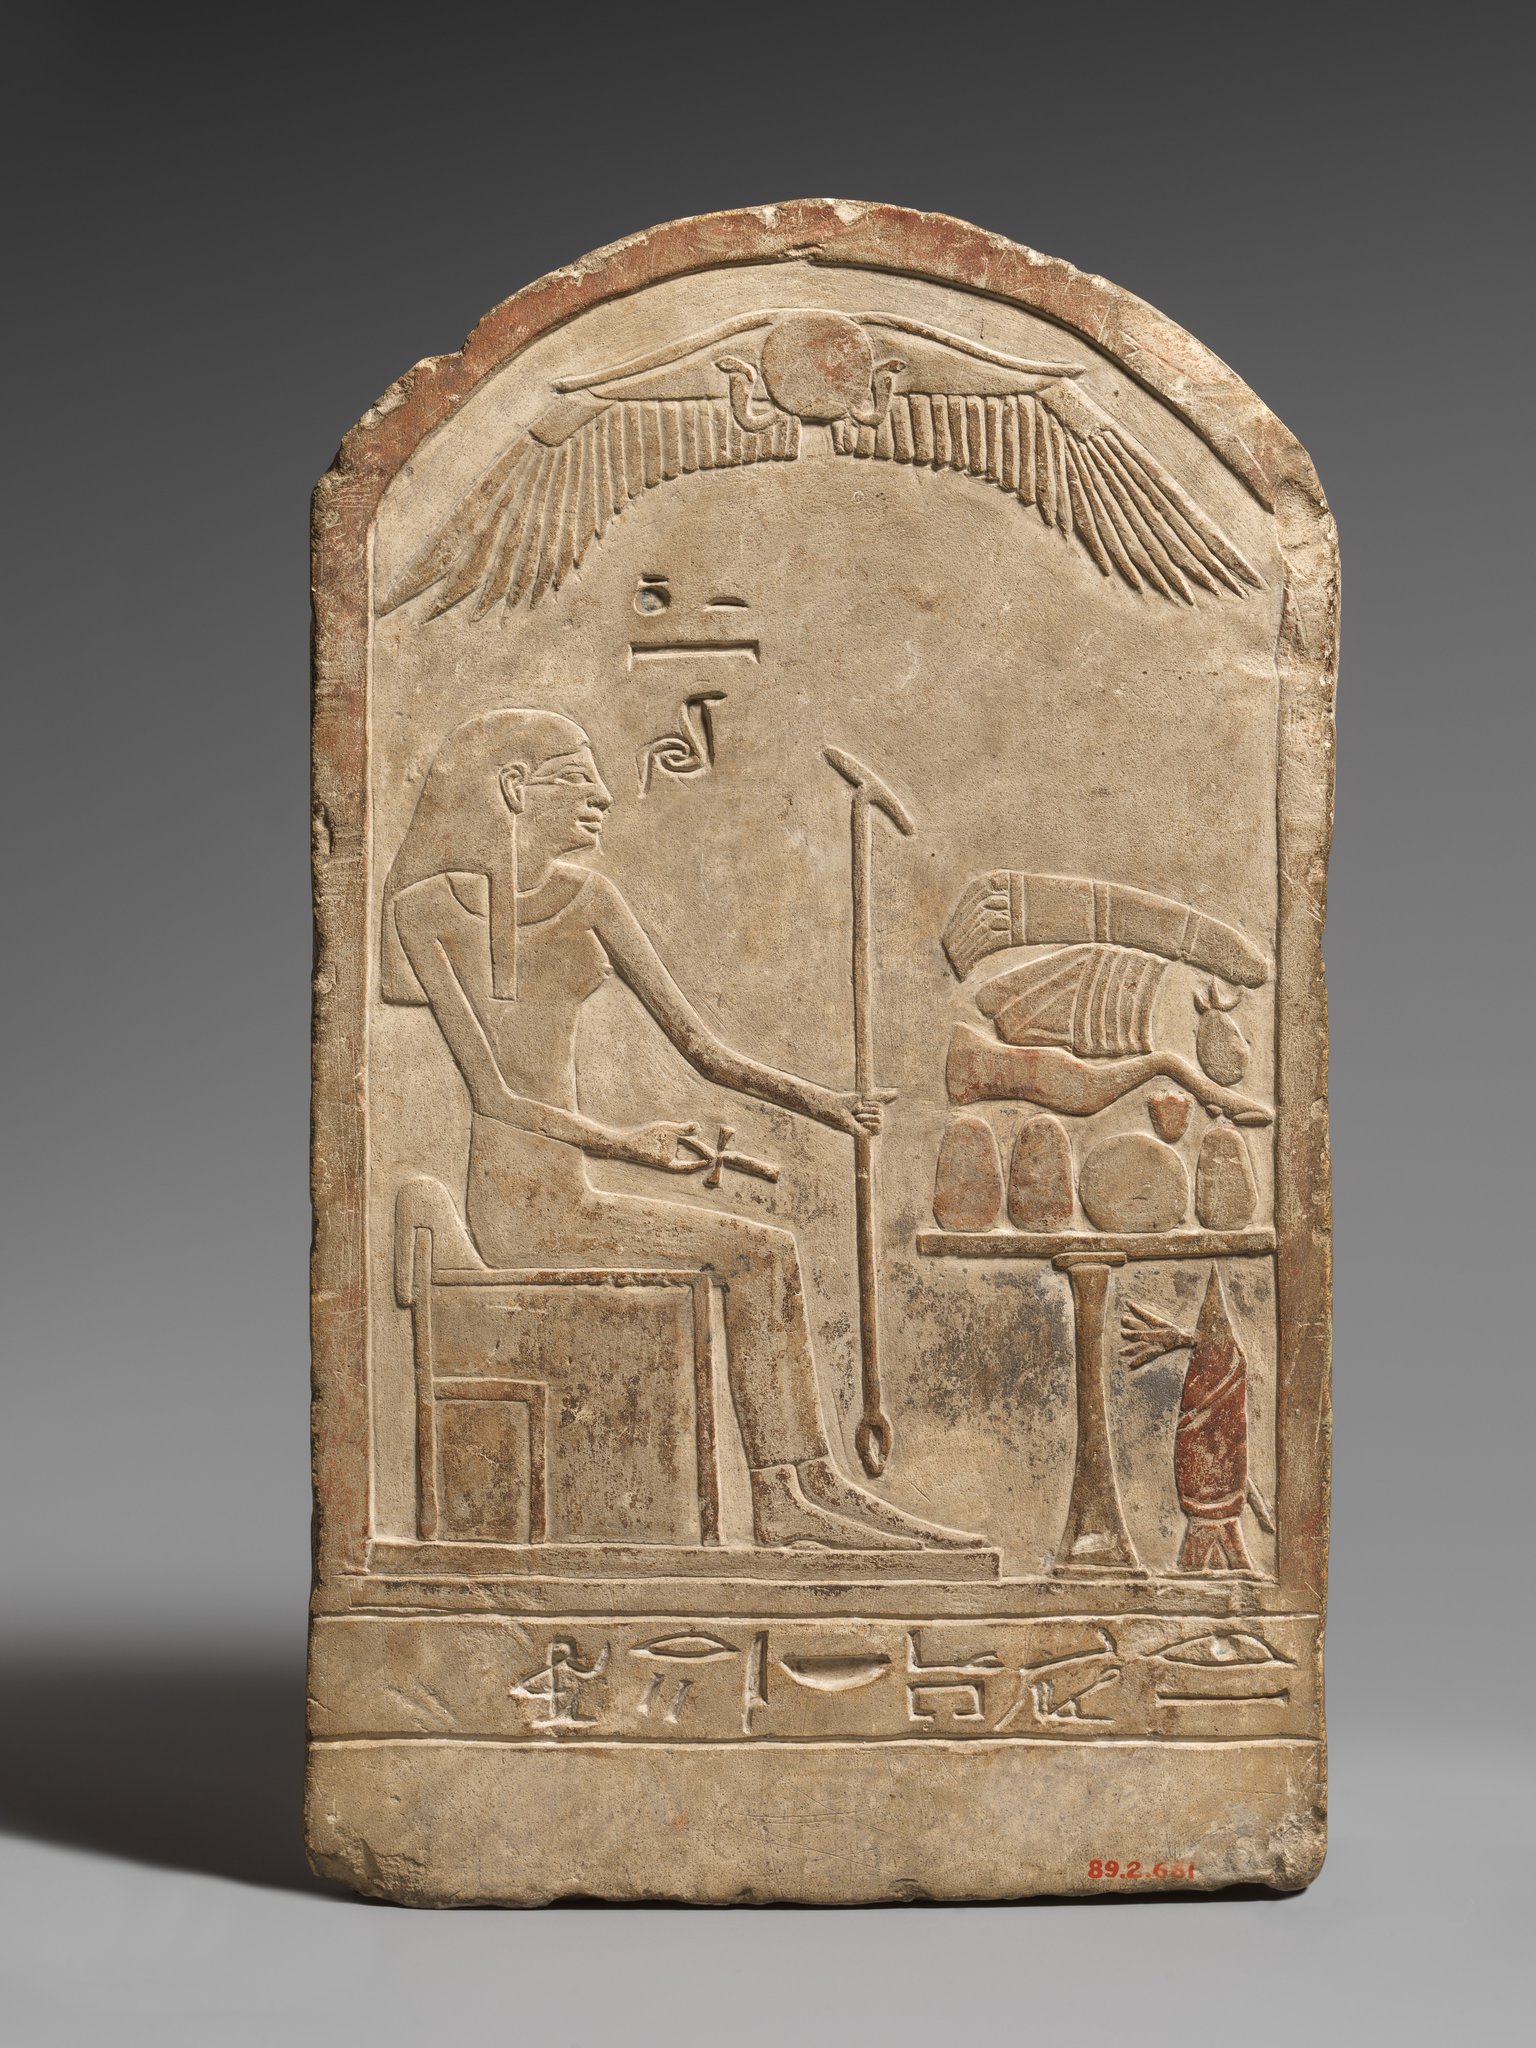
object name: stela, nut, offering table, nebiry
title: Stela dedicated by Nebiry depicting Nut before an offering table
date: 1550-1295 BCE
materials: limestone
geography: egypt